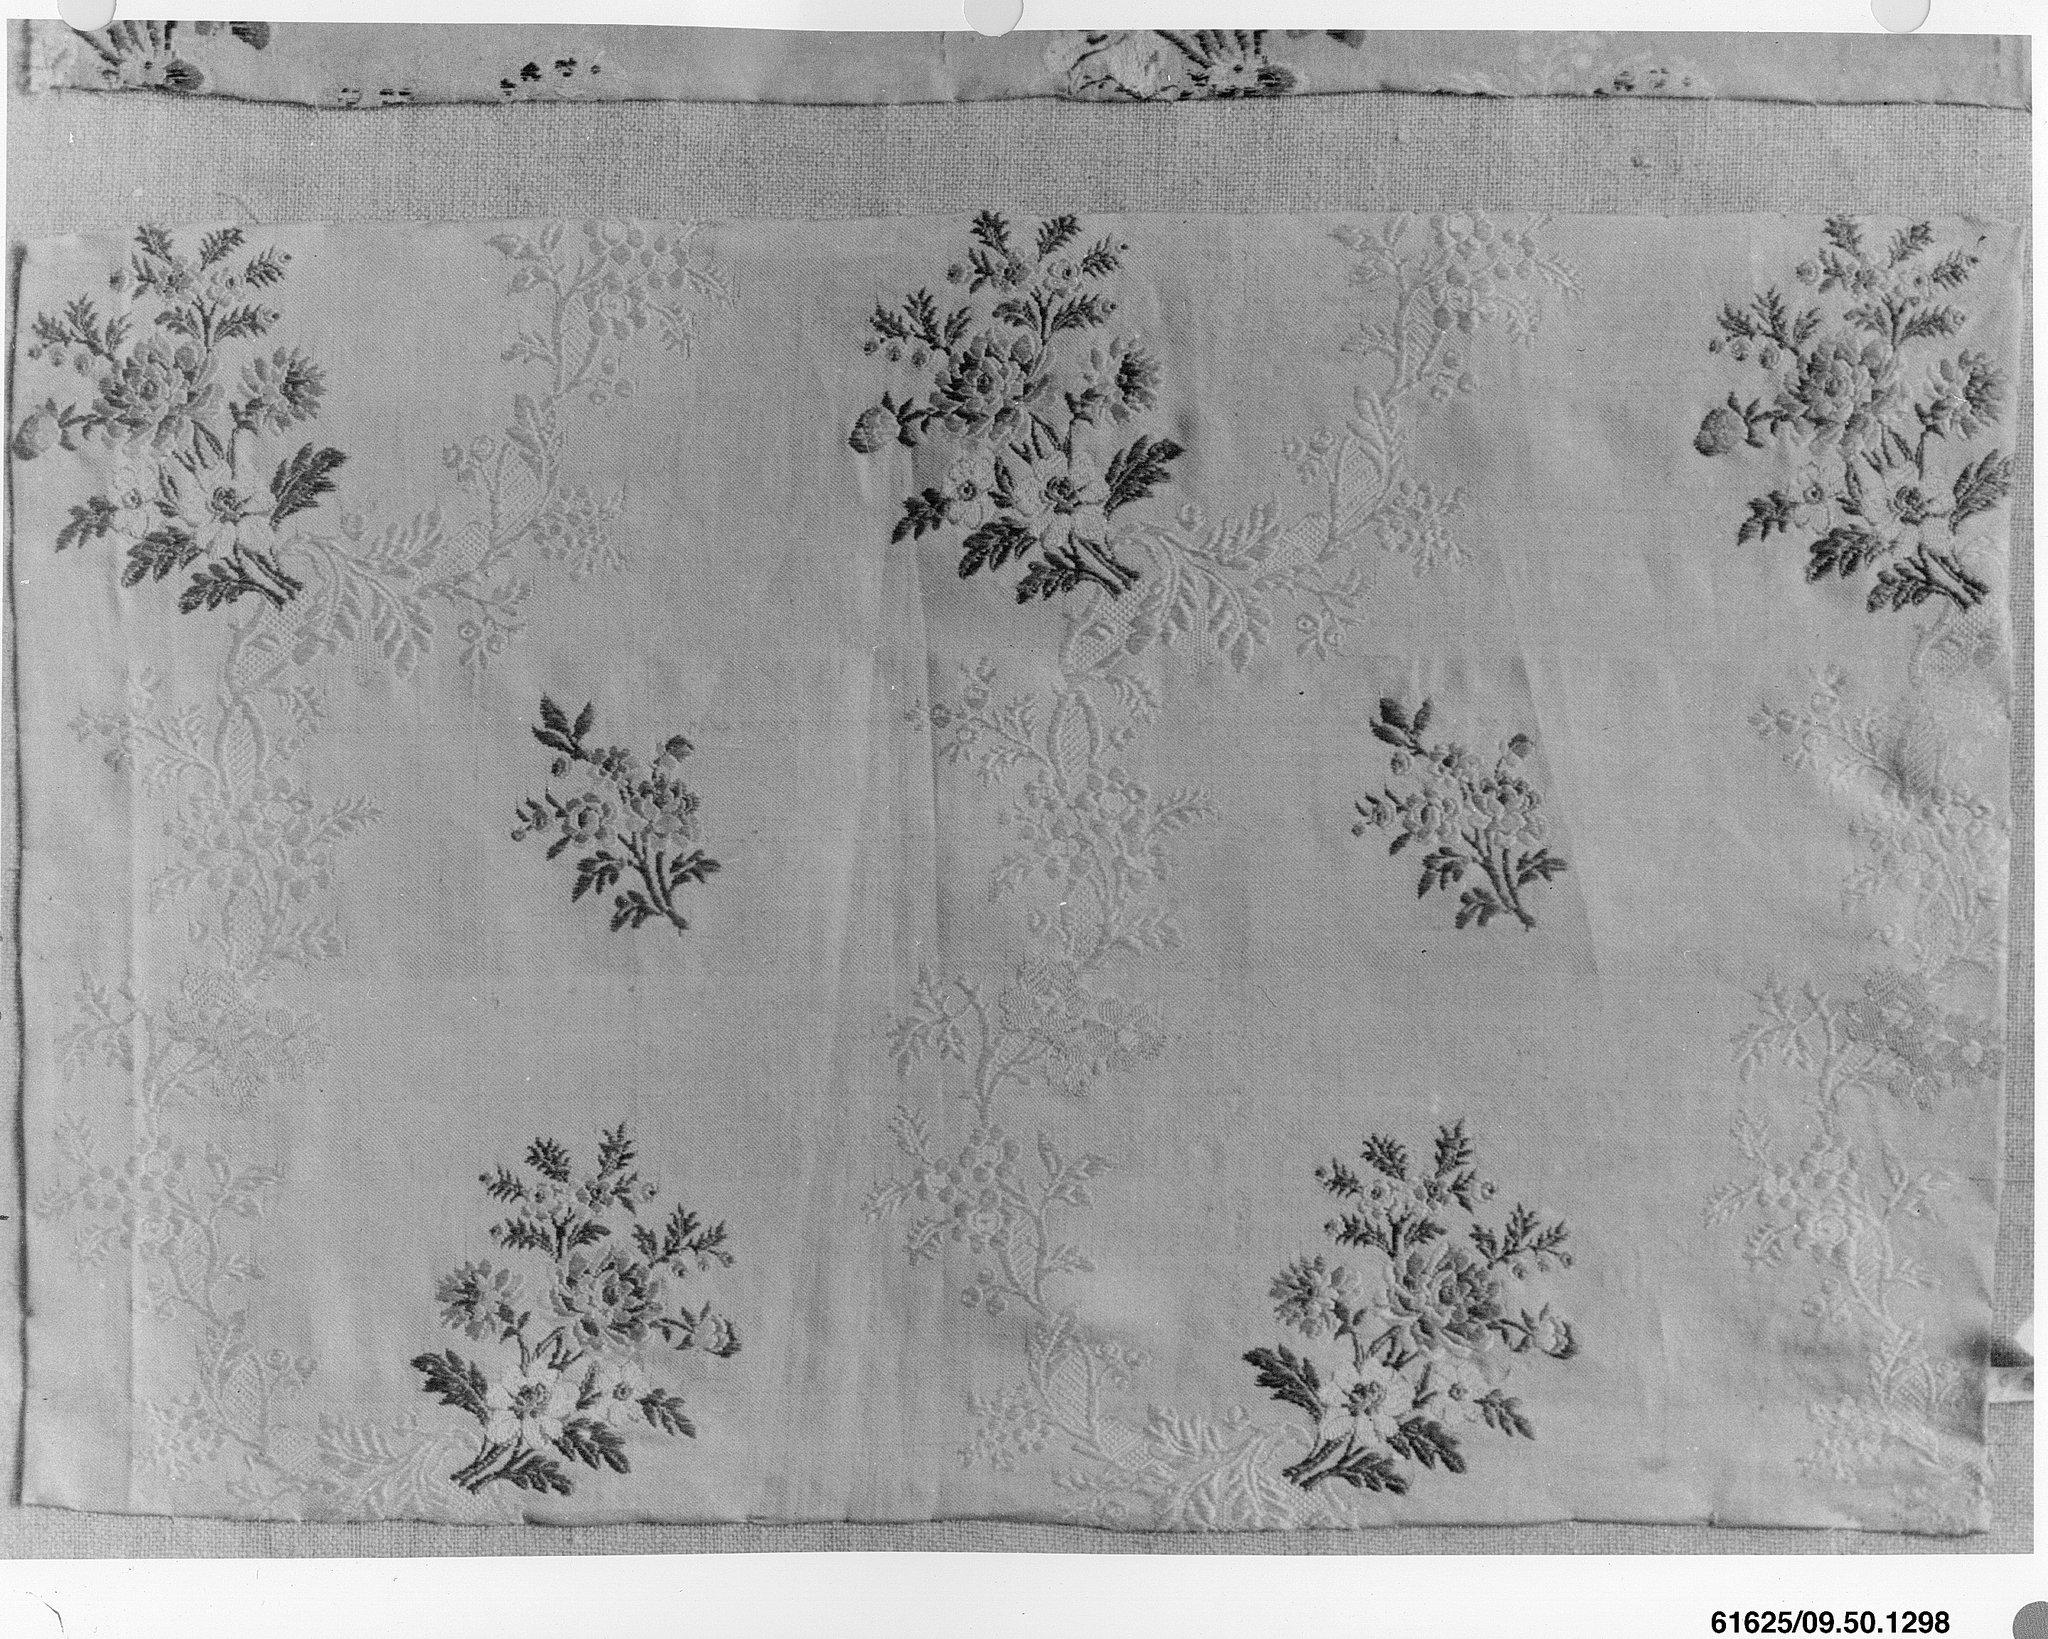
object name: piece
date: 1760-1770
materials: silk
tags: flowers,leaves